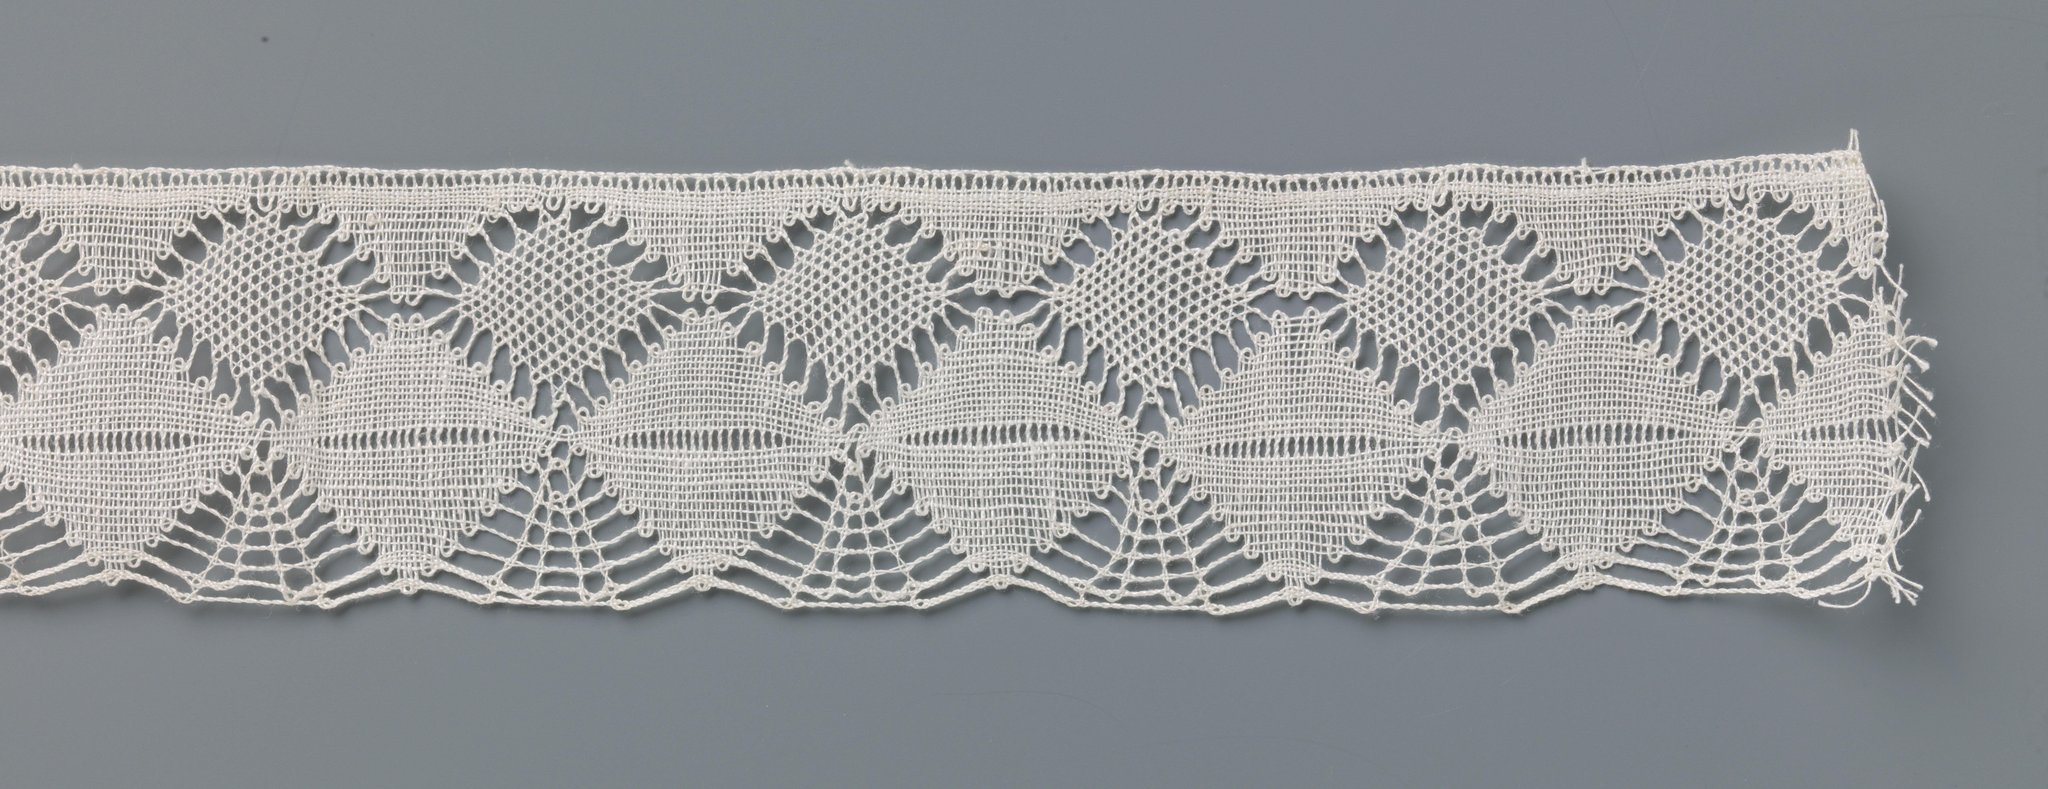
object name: strip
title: Strook kloskant met spinneweb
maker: wilhelmina cornelia schutten-putters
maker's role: designer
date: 1920-1929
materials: linen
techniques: lace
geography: hoorn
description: Strook naturelkleurige kloskant: Cluny-kant. Patroon met rijen in elkaar passende ruiten, die met elkaar verbonden zijn door een grond van lange vlechten. Zwak geschulpte rand van lange spinneweb-spijlen.